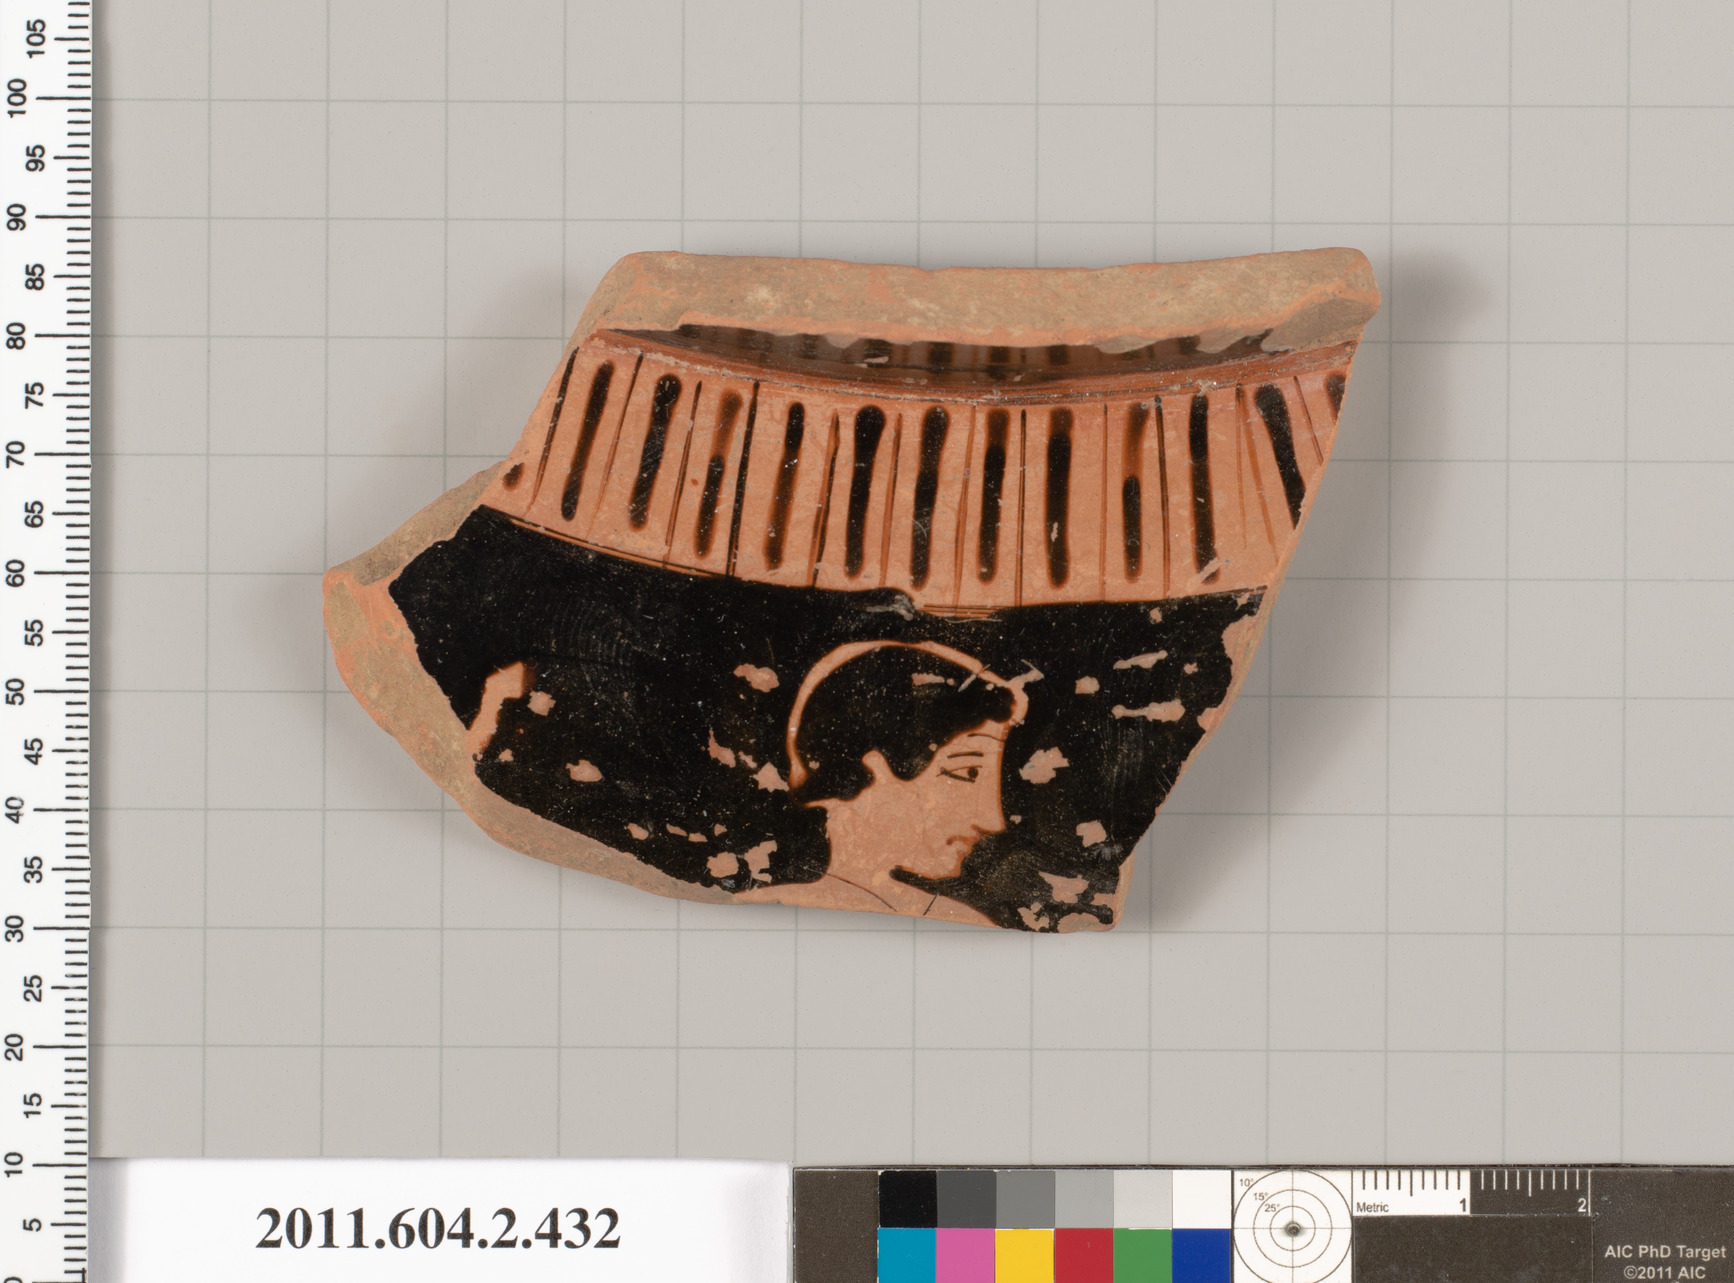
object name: stamnos fragment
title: Terracotta fragment of a stamnos (jar)?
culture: greek, attic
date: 450-440 BCE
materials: terracotta